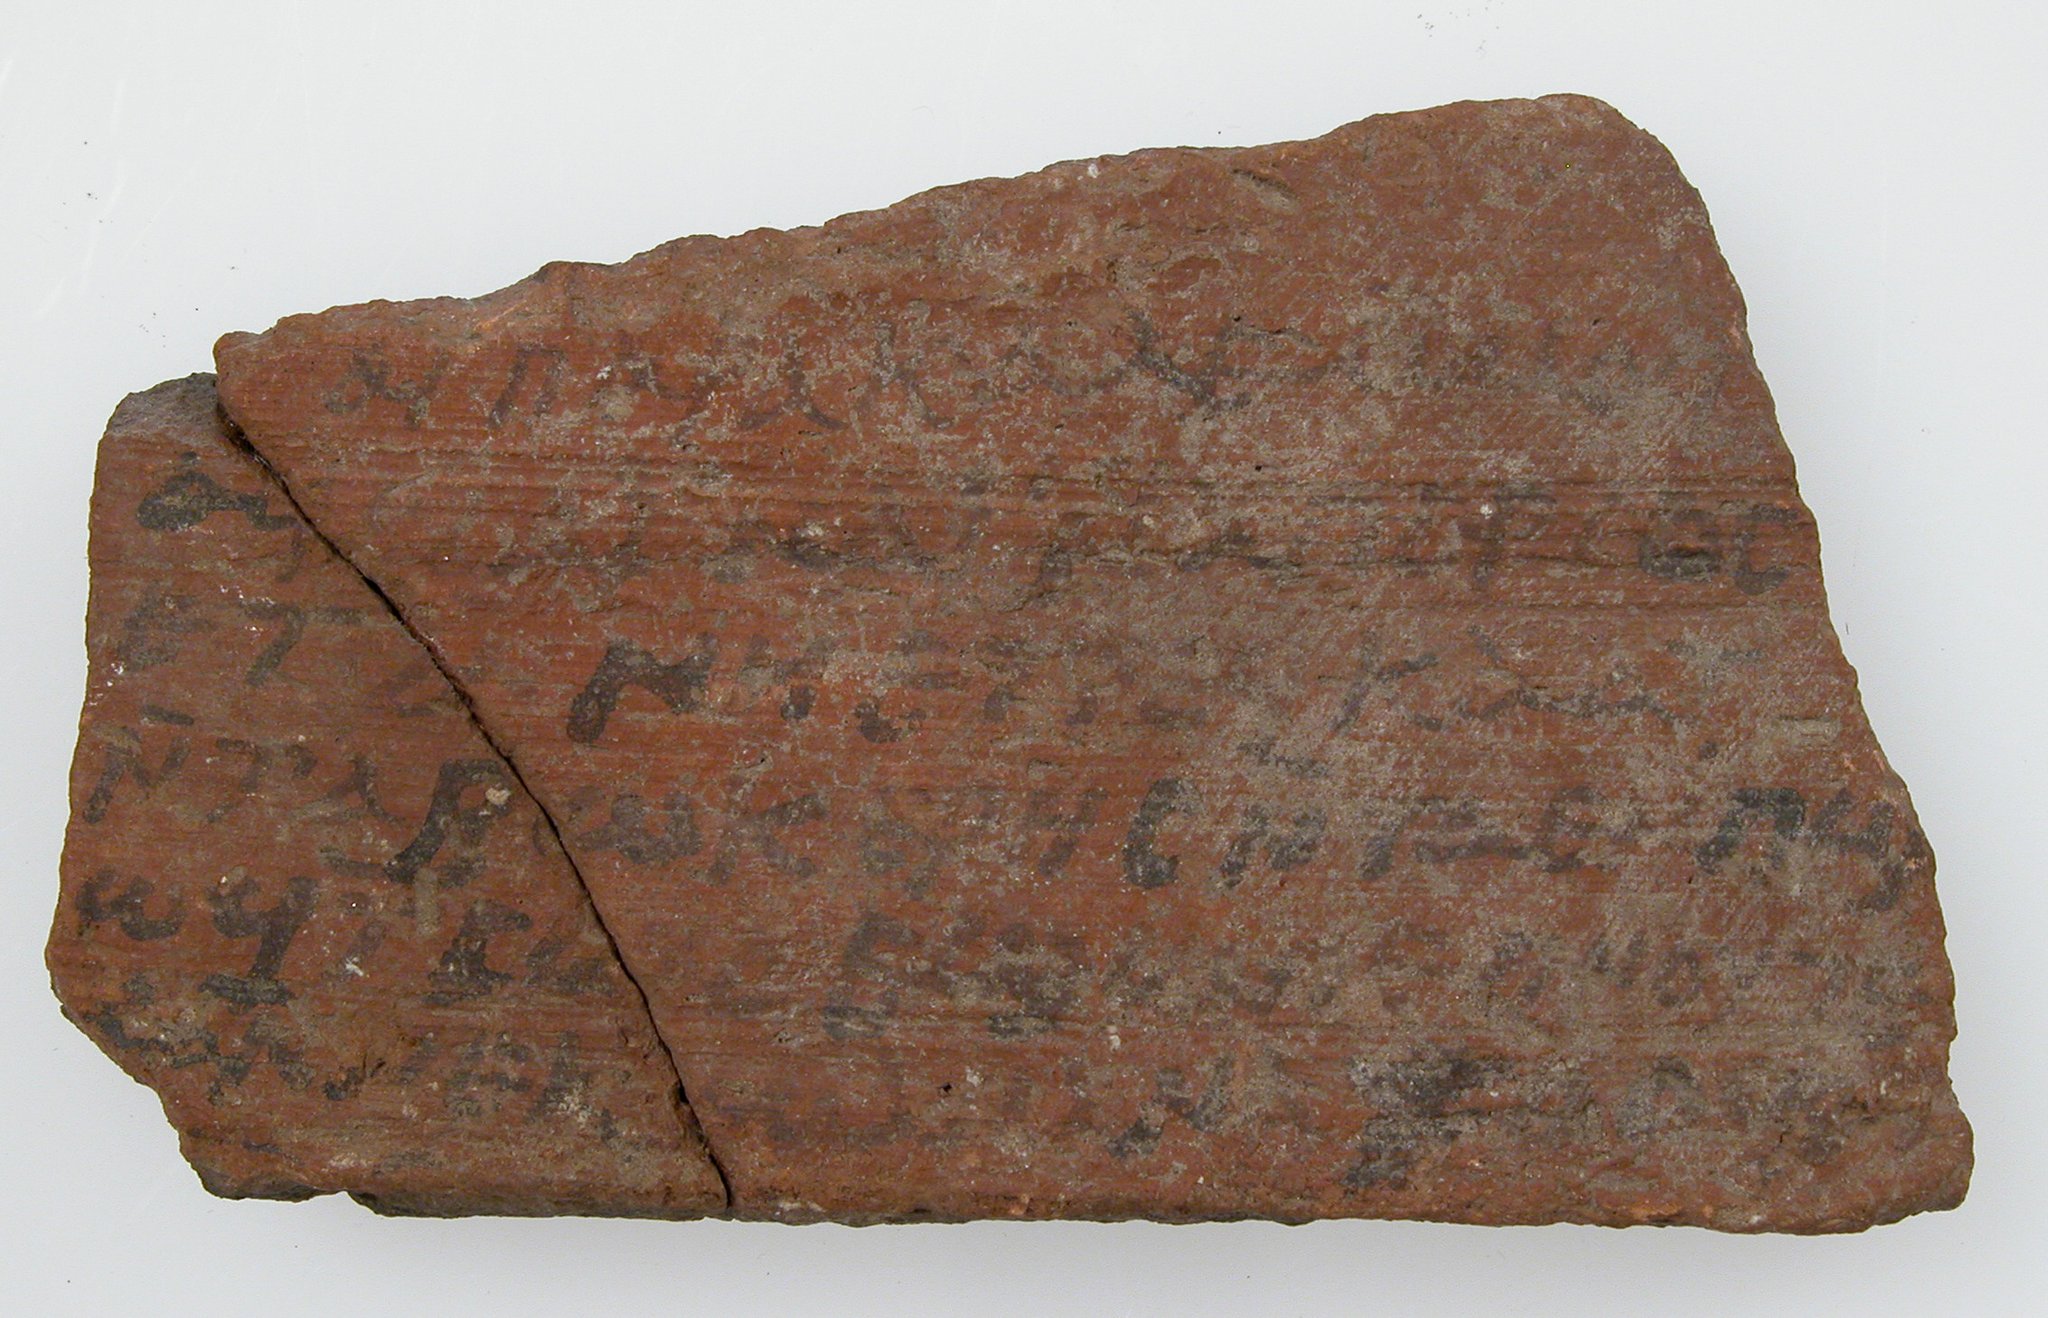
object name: ostrakon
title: Ostrakon with a Letter Referring to the Persian Occupation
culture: coptic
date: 618-629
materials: ink, pottery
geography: egypt